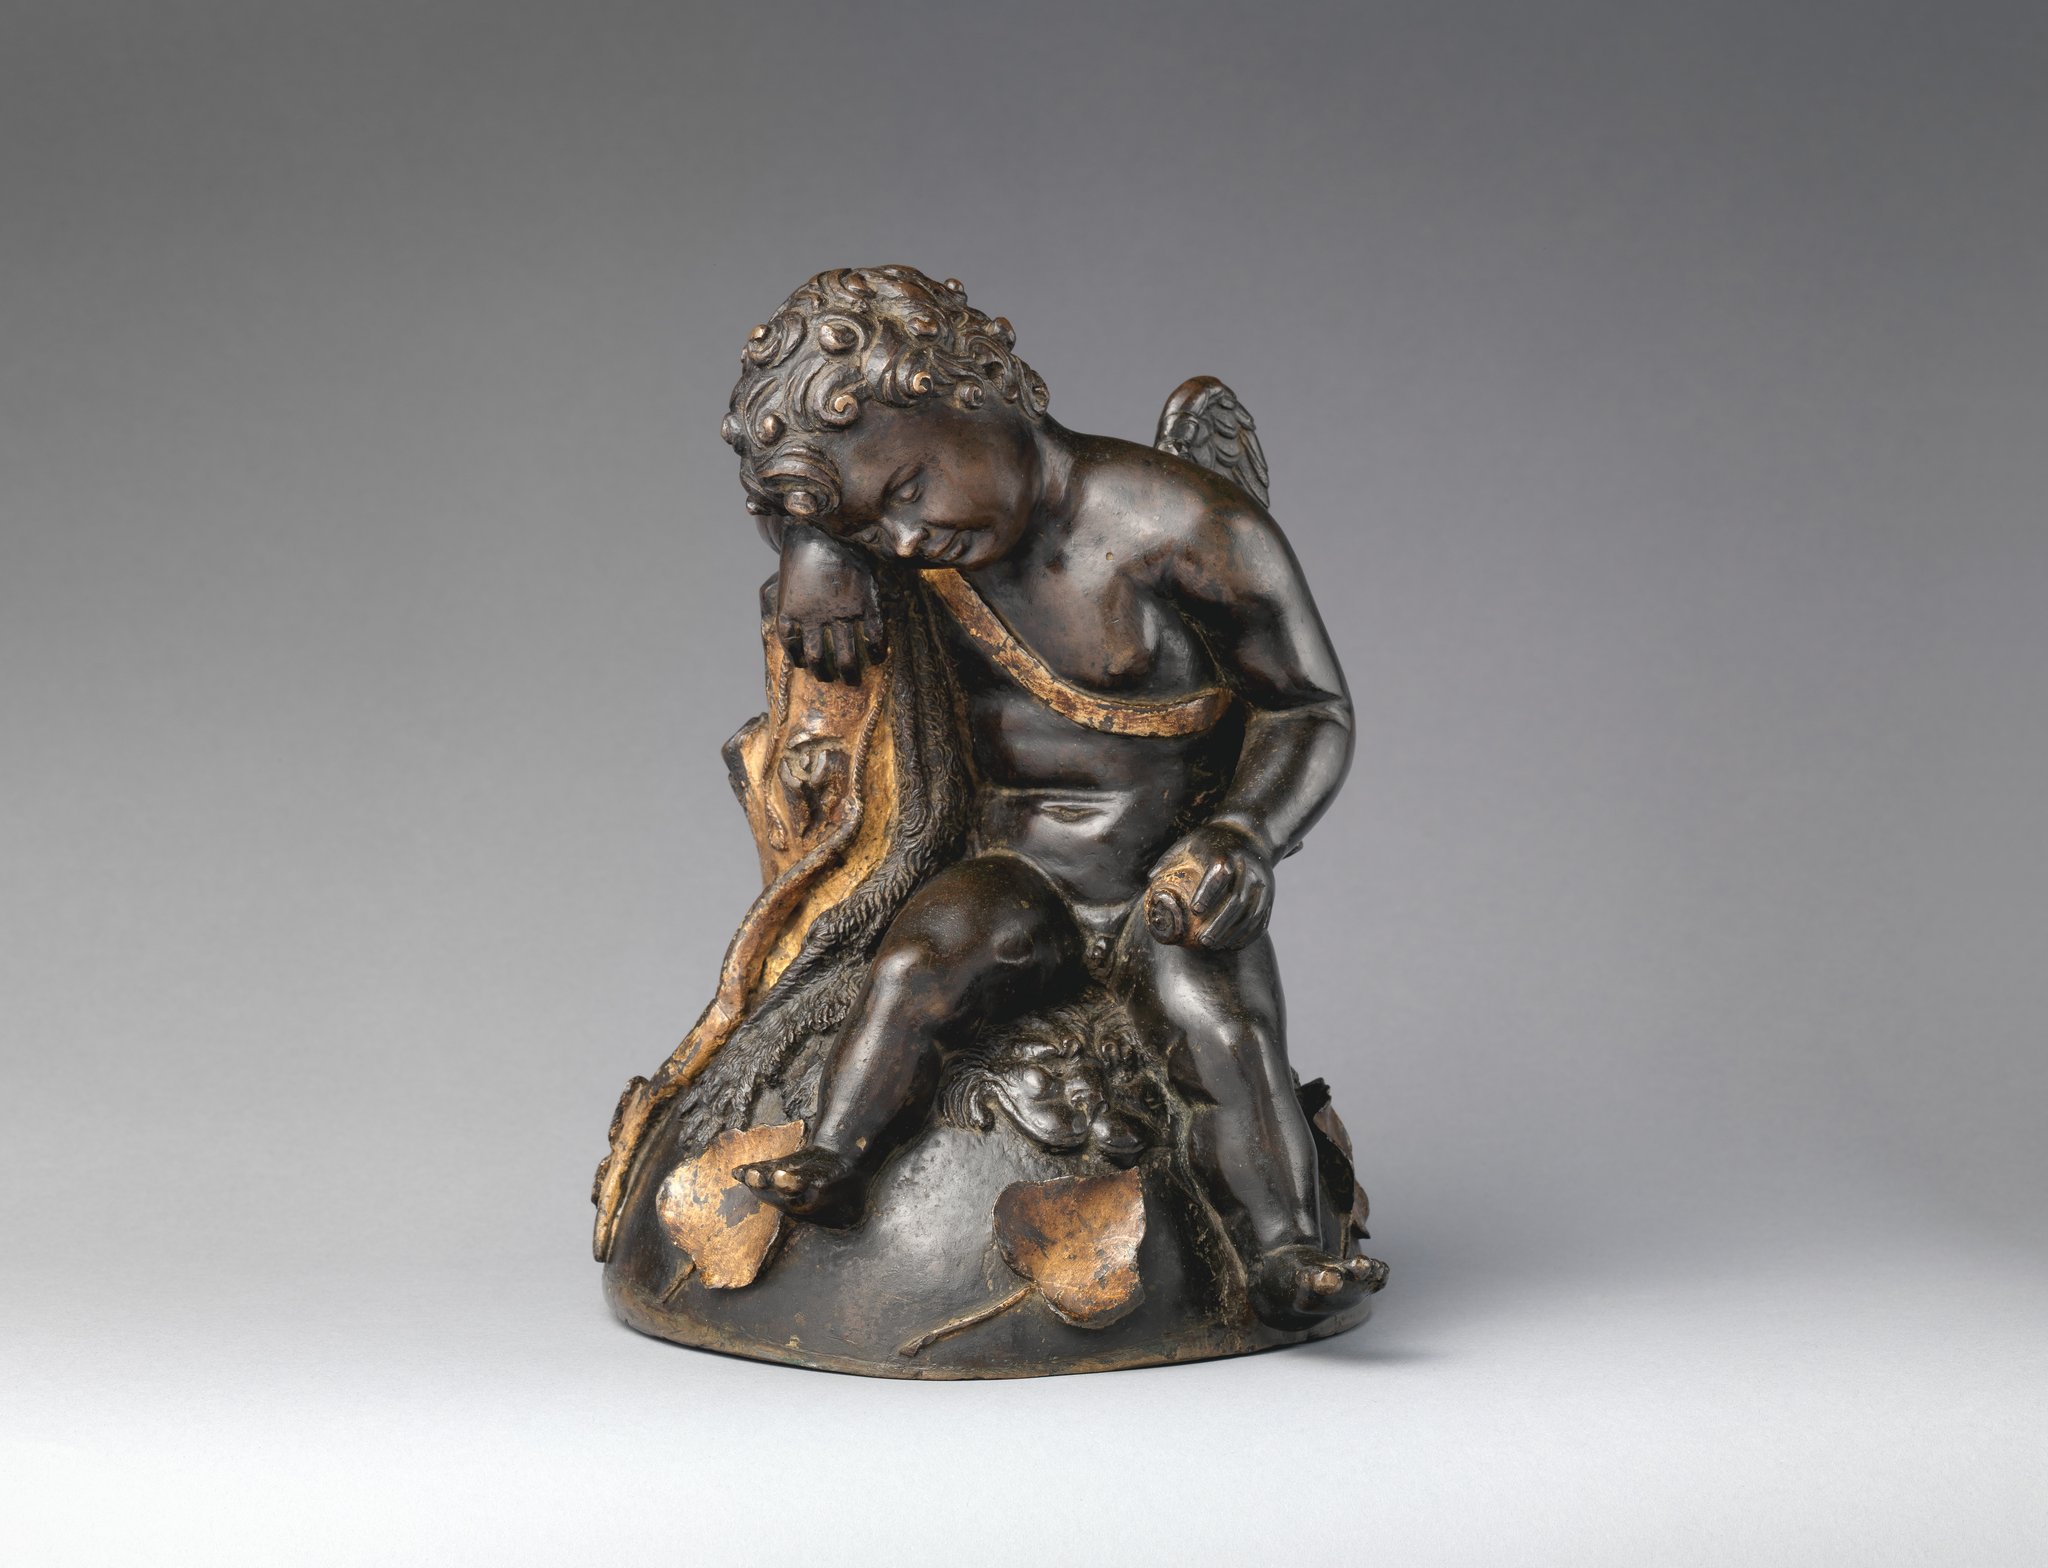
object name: statuette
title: Sleeping Cupid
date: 1501-1533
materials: bronze, gilt, oil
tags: cupid